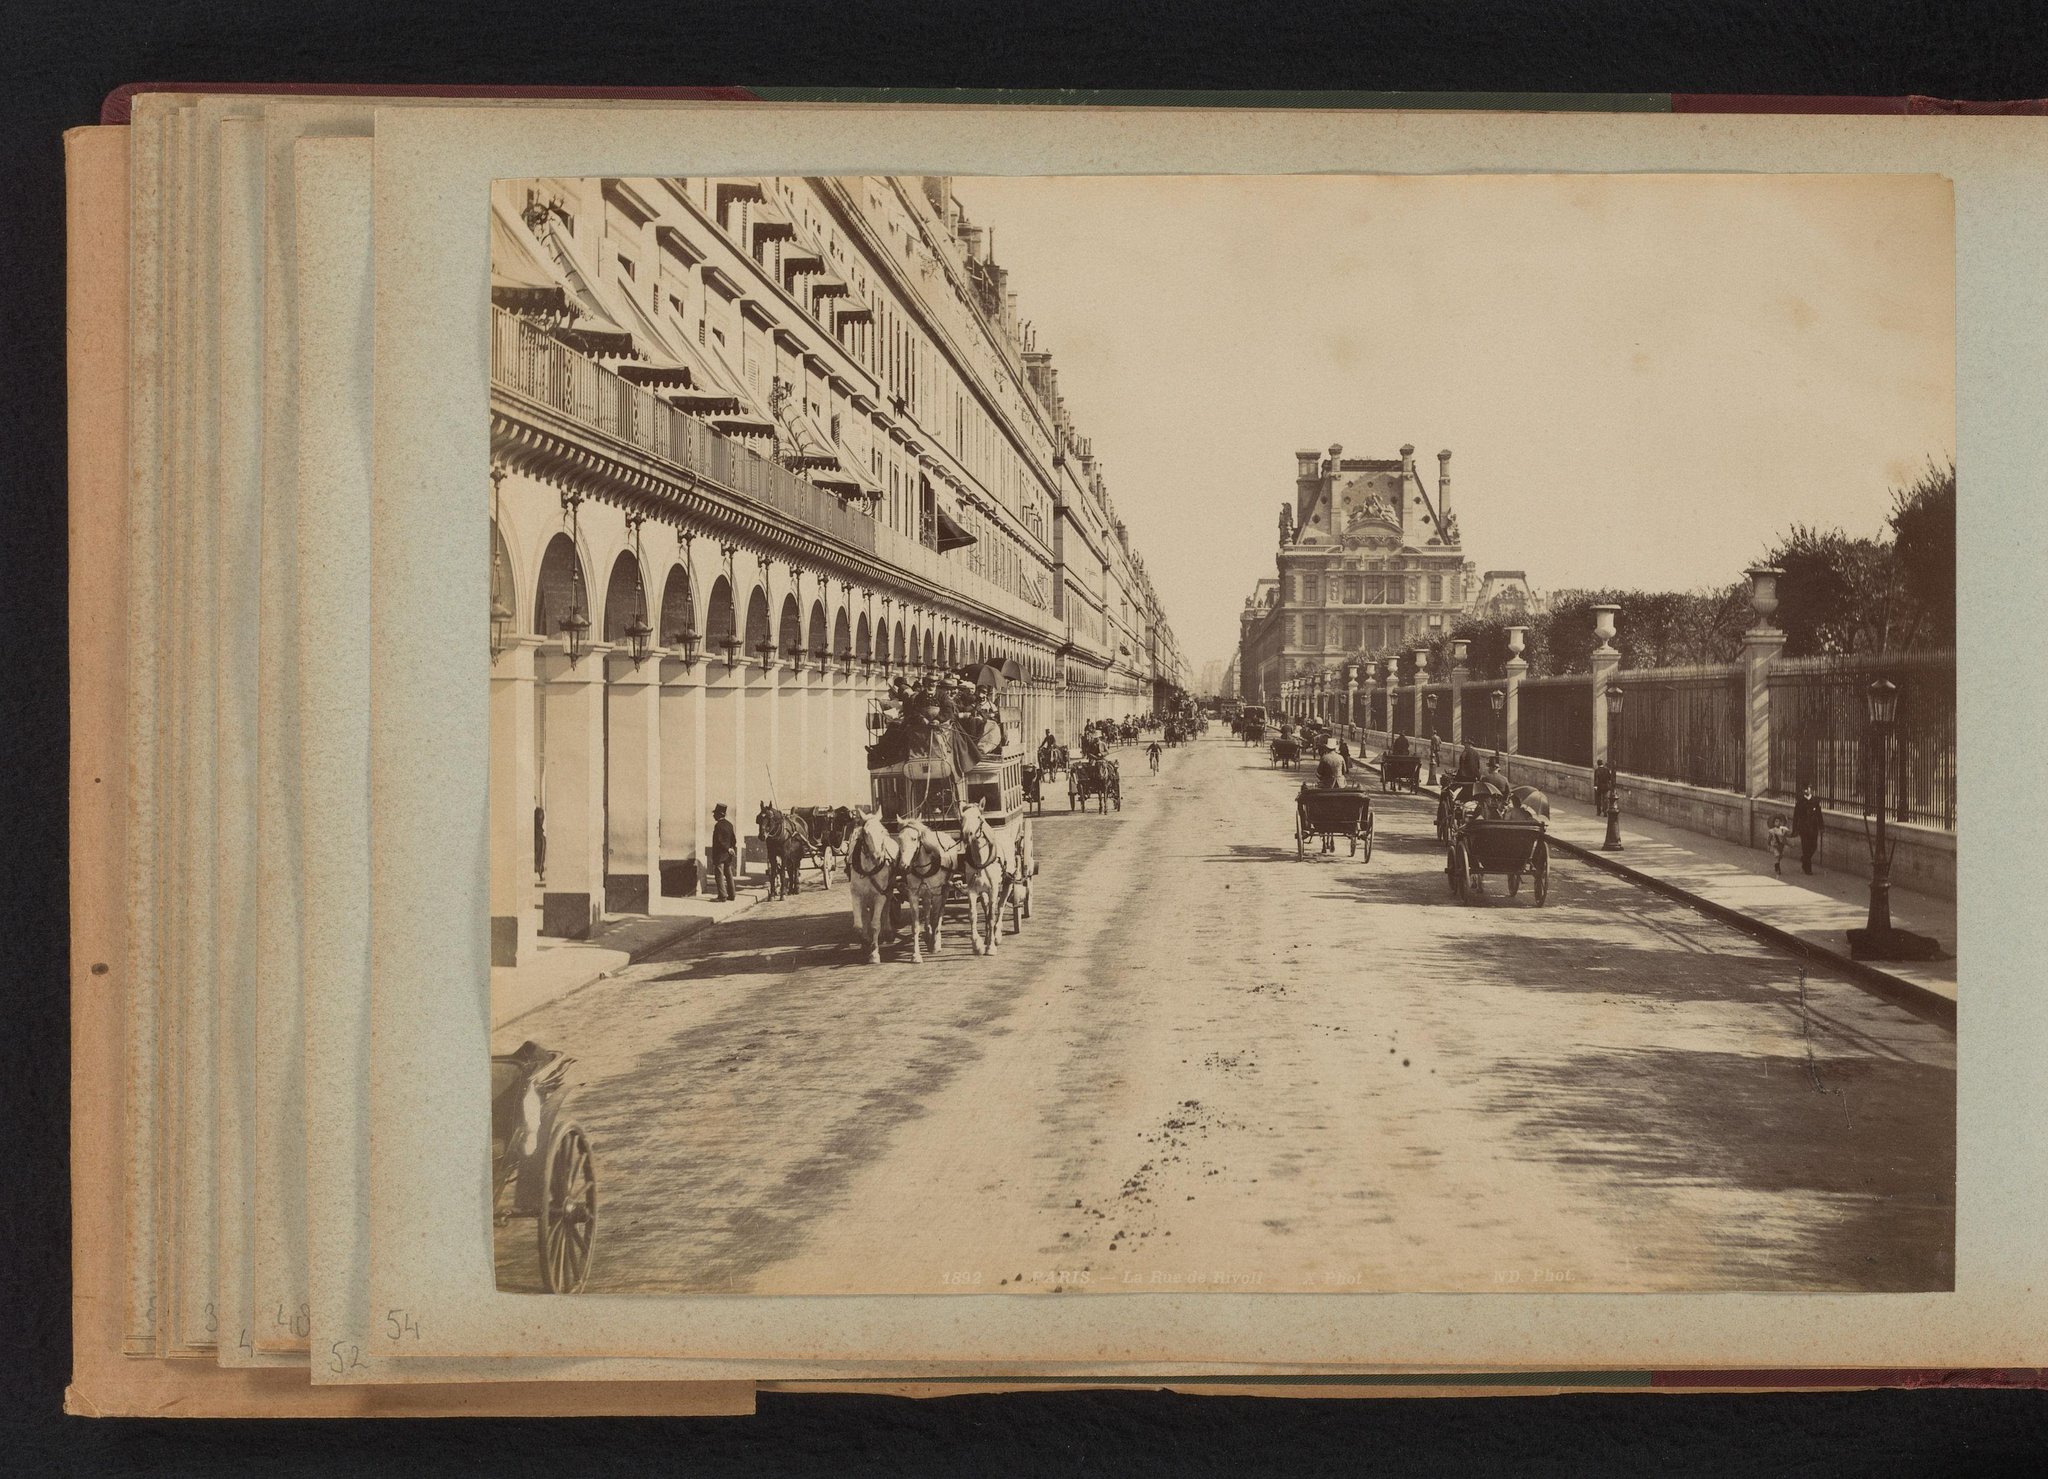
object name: photograph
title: La Rue de Rivoli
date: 1887-1900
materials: paper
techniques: albumen print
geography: paris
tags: diligence, omnibus, horse-tram, street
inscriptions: number: ‘1892’